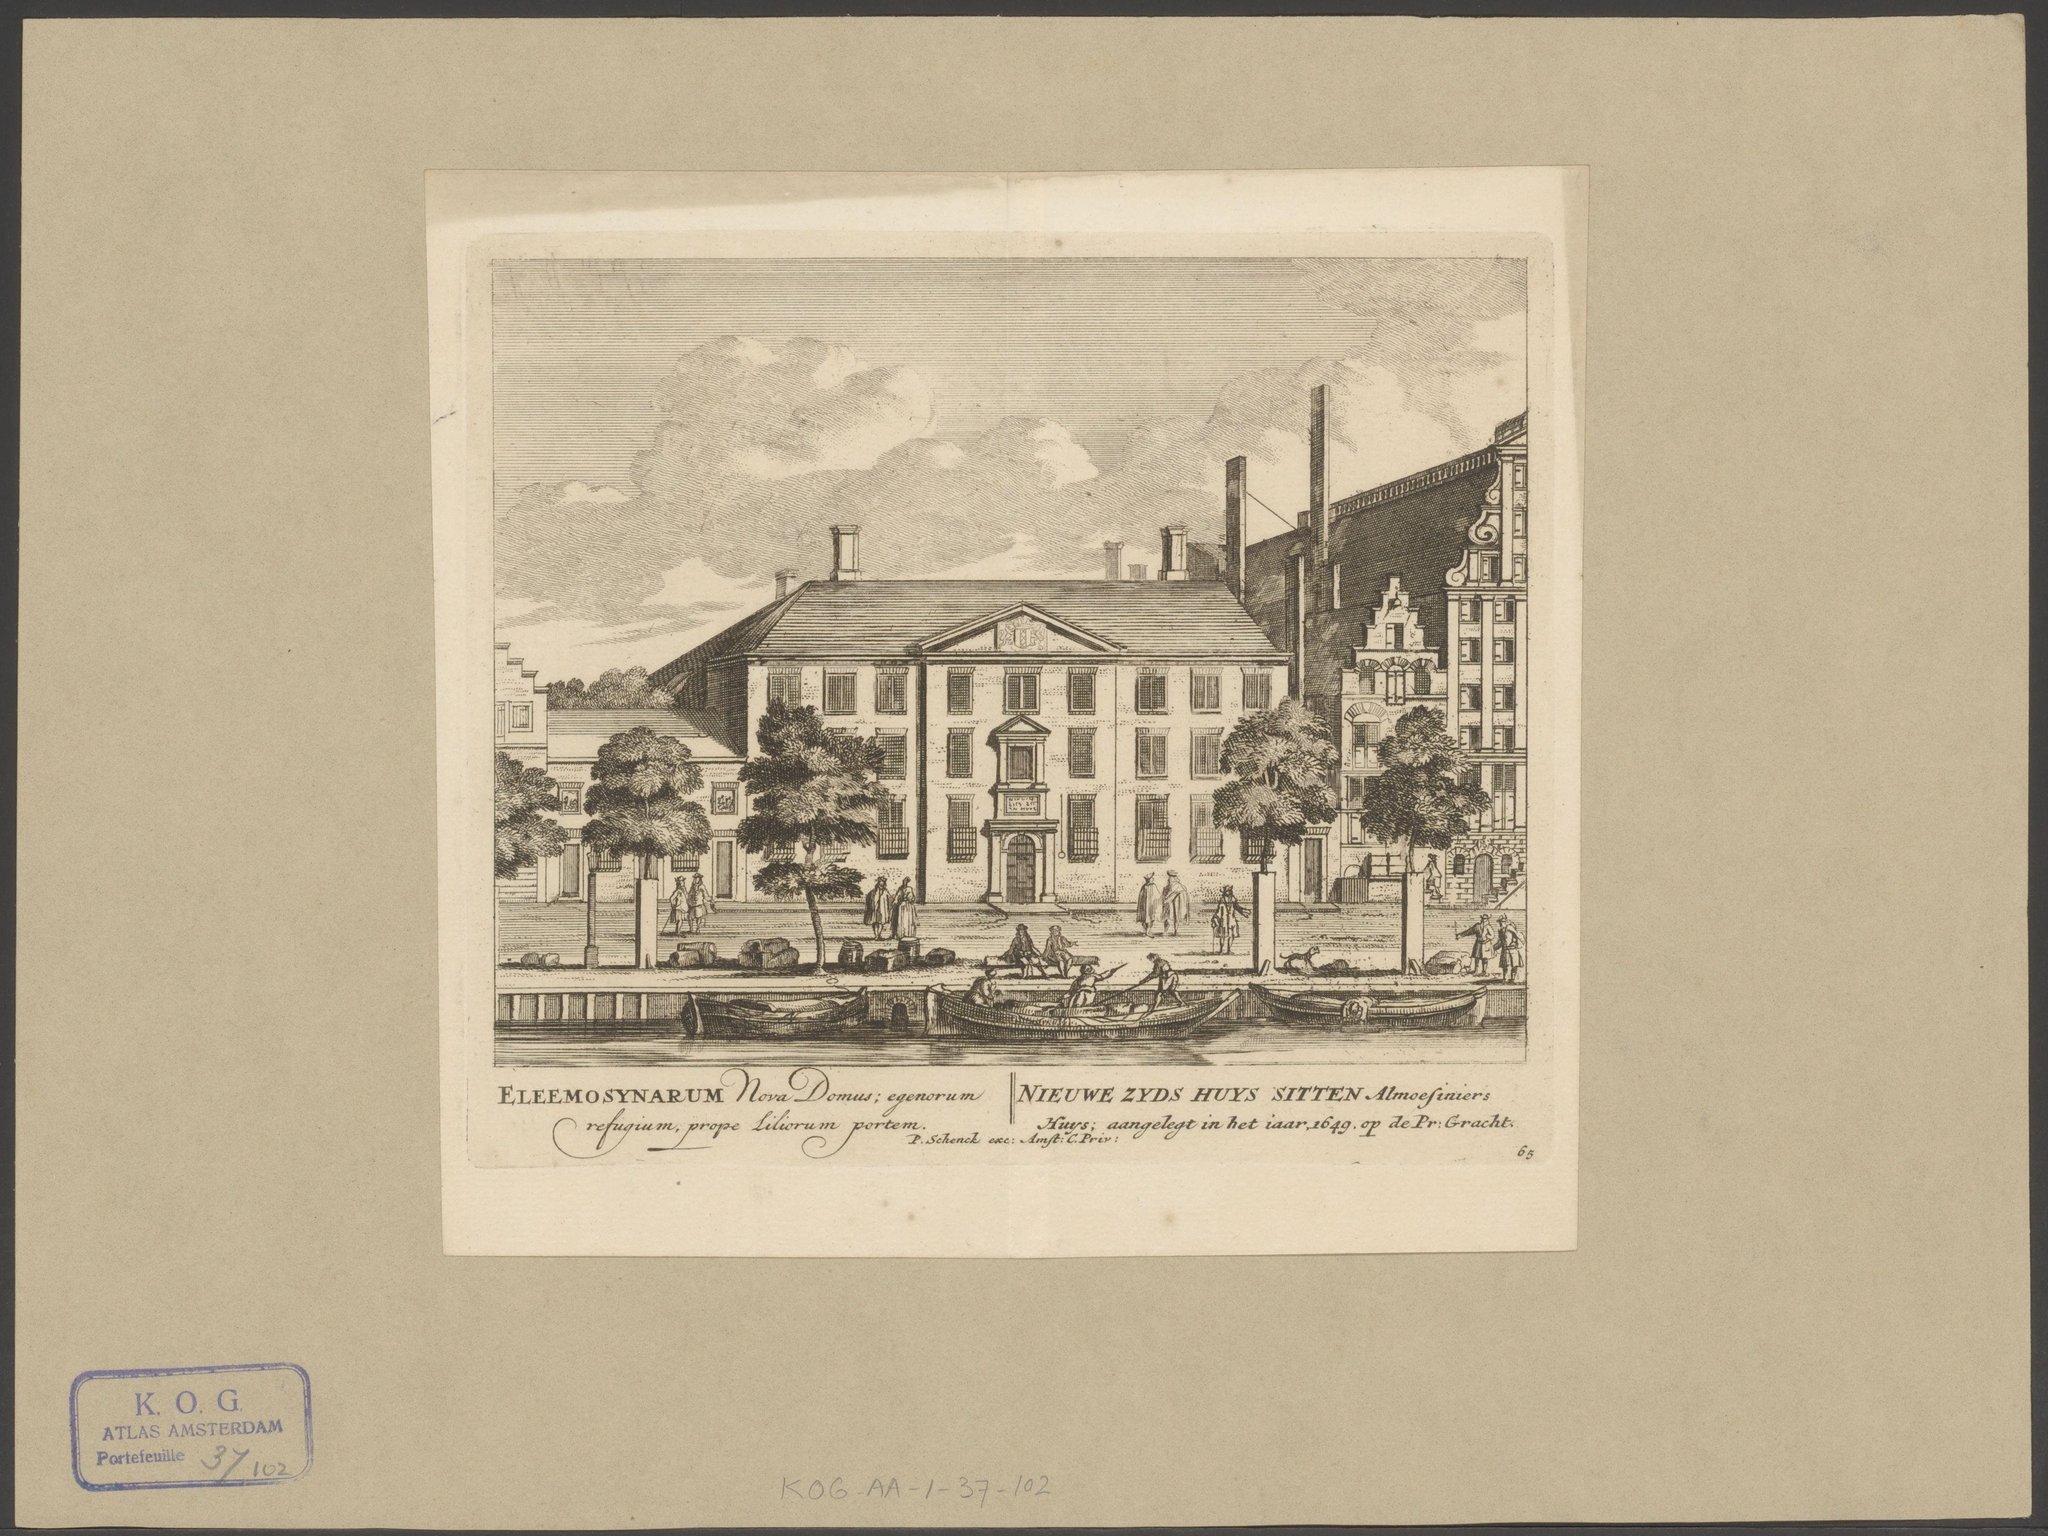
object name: print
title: Gezicht op het Nieuwezijds Huiszittenhuis te Amsterdam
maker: Anonymous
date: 1710-1711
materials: paper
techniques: engraving, etching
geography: northern netherlands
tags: poorhouse, ships (in general), canals, waters (in city) (+ city(-scape) with figures, staffage)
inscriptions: collector's mark: Lugt 1641b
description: Prent mogelijk uit: 100 Afbeeldinge der voornaamste gebouwen van Amsterdam. Amsterdam: Pieter Schenk (I), s.a. [1710-1711]. Of uit: 100 Afbeeldinge der voornaamste gebouwen van Amsterdam. Amsterdam: Barent Greve, s.a. [1757-1766]. In de tweede uitgave, uitgegeven door Barent Greve, is alleen de titelprent aangepast. De overige prenten zijn onveranderd gebleven.